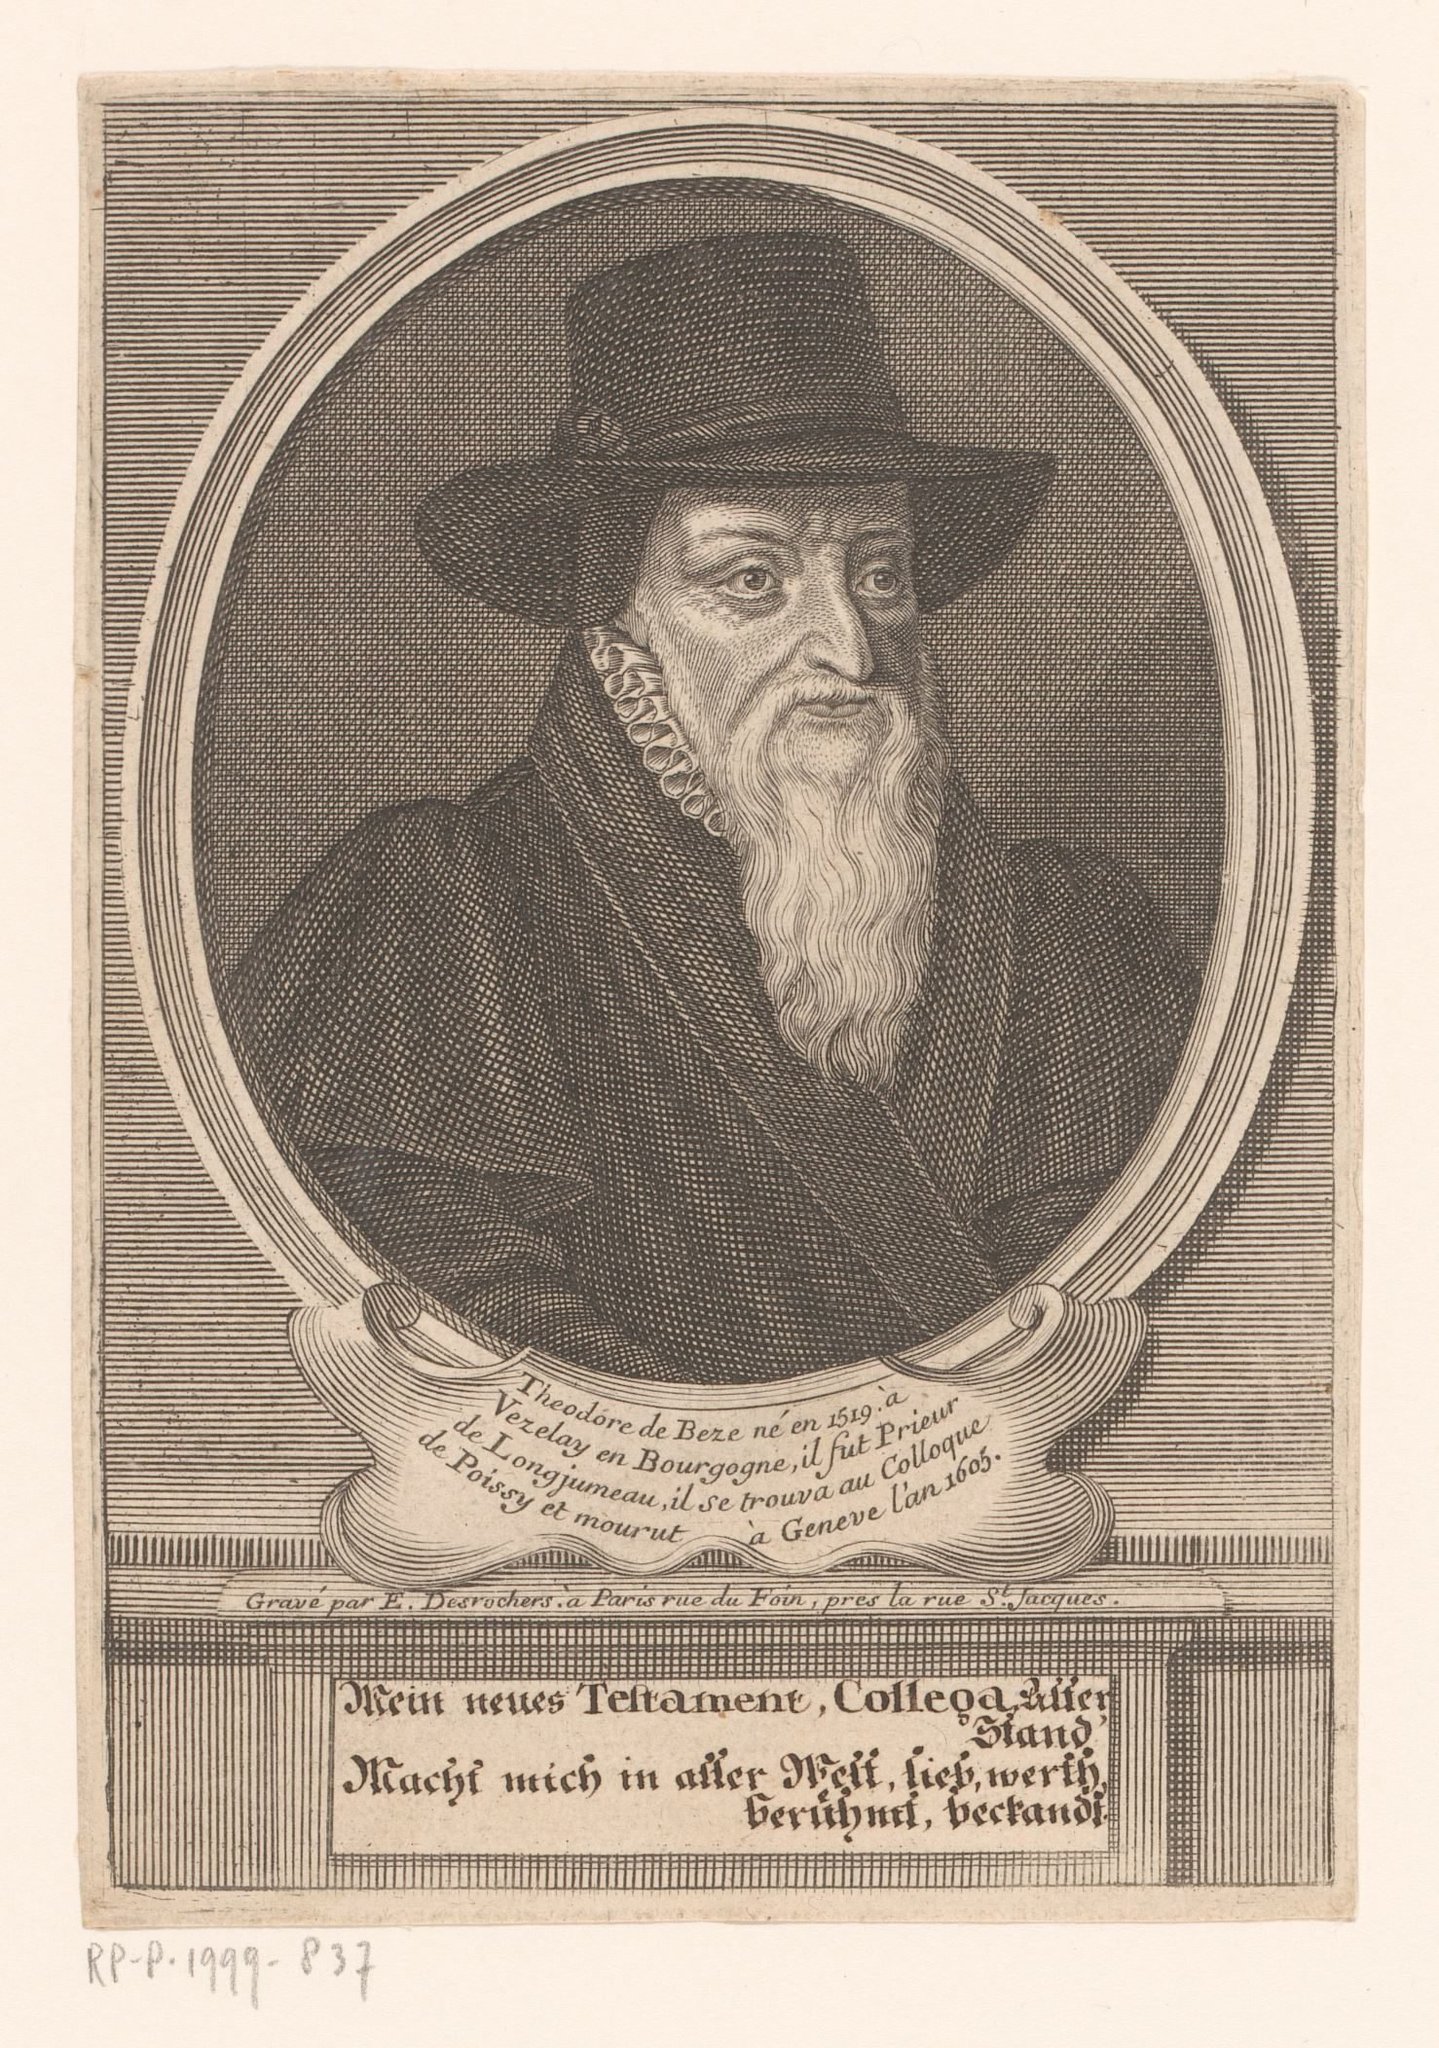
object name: print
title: Recueil de portraits (...)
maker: étienne desrochers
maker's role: print maker, publisher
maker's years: 1668-1741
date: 1726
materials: paper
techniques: engraving, etching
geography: paris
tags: theodorus beza, theologian, historical persons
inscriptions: collector's mark: Lugt 2760, collector's mark: Lugt 2228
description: Behoort waarschijnlijk tot een serie portretten, grotendeels door Etienne Desrochers, getiteld: 'Recueil de portraits de personnes qui se sont distinguées tant dans les Armes que dans Belles-Lettres et les Arts, comme aussi la famille royale de France et autres cours étrangères'. De serie werd initieel uitgegeven door Desrochers en aangekondigd in 'Mercure' in mei 1726, p. 985. Echter was Desrochers reeds enkele jaren eerder begonnen met het uitgeven van de serie. Na de dood van Desrochers werd de serie voortgezet door Gilles Edme Petit. Een latere staat werd uitgegeven door Jean François Daumont in Parijs.